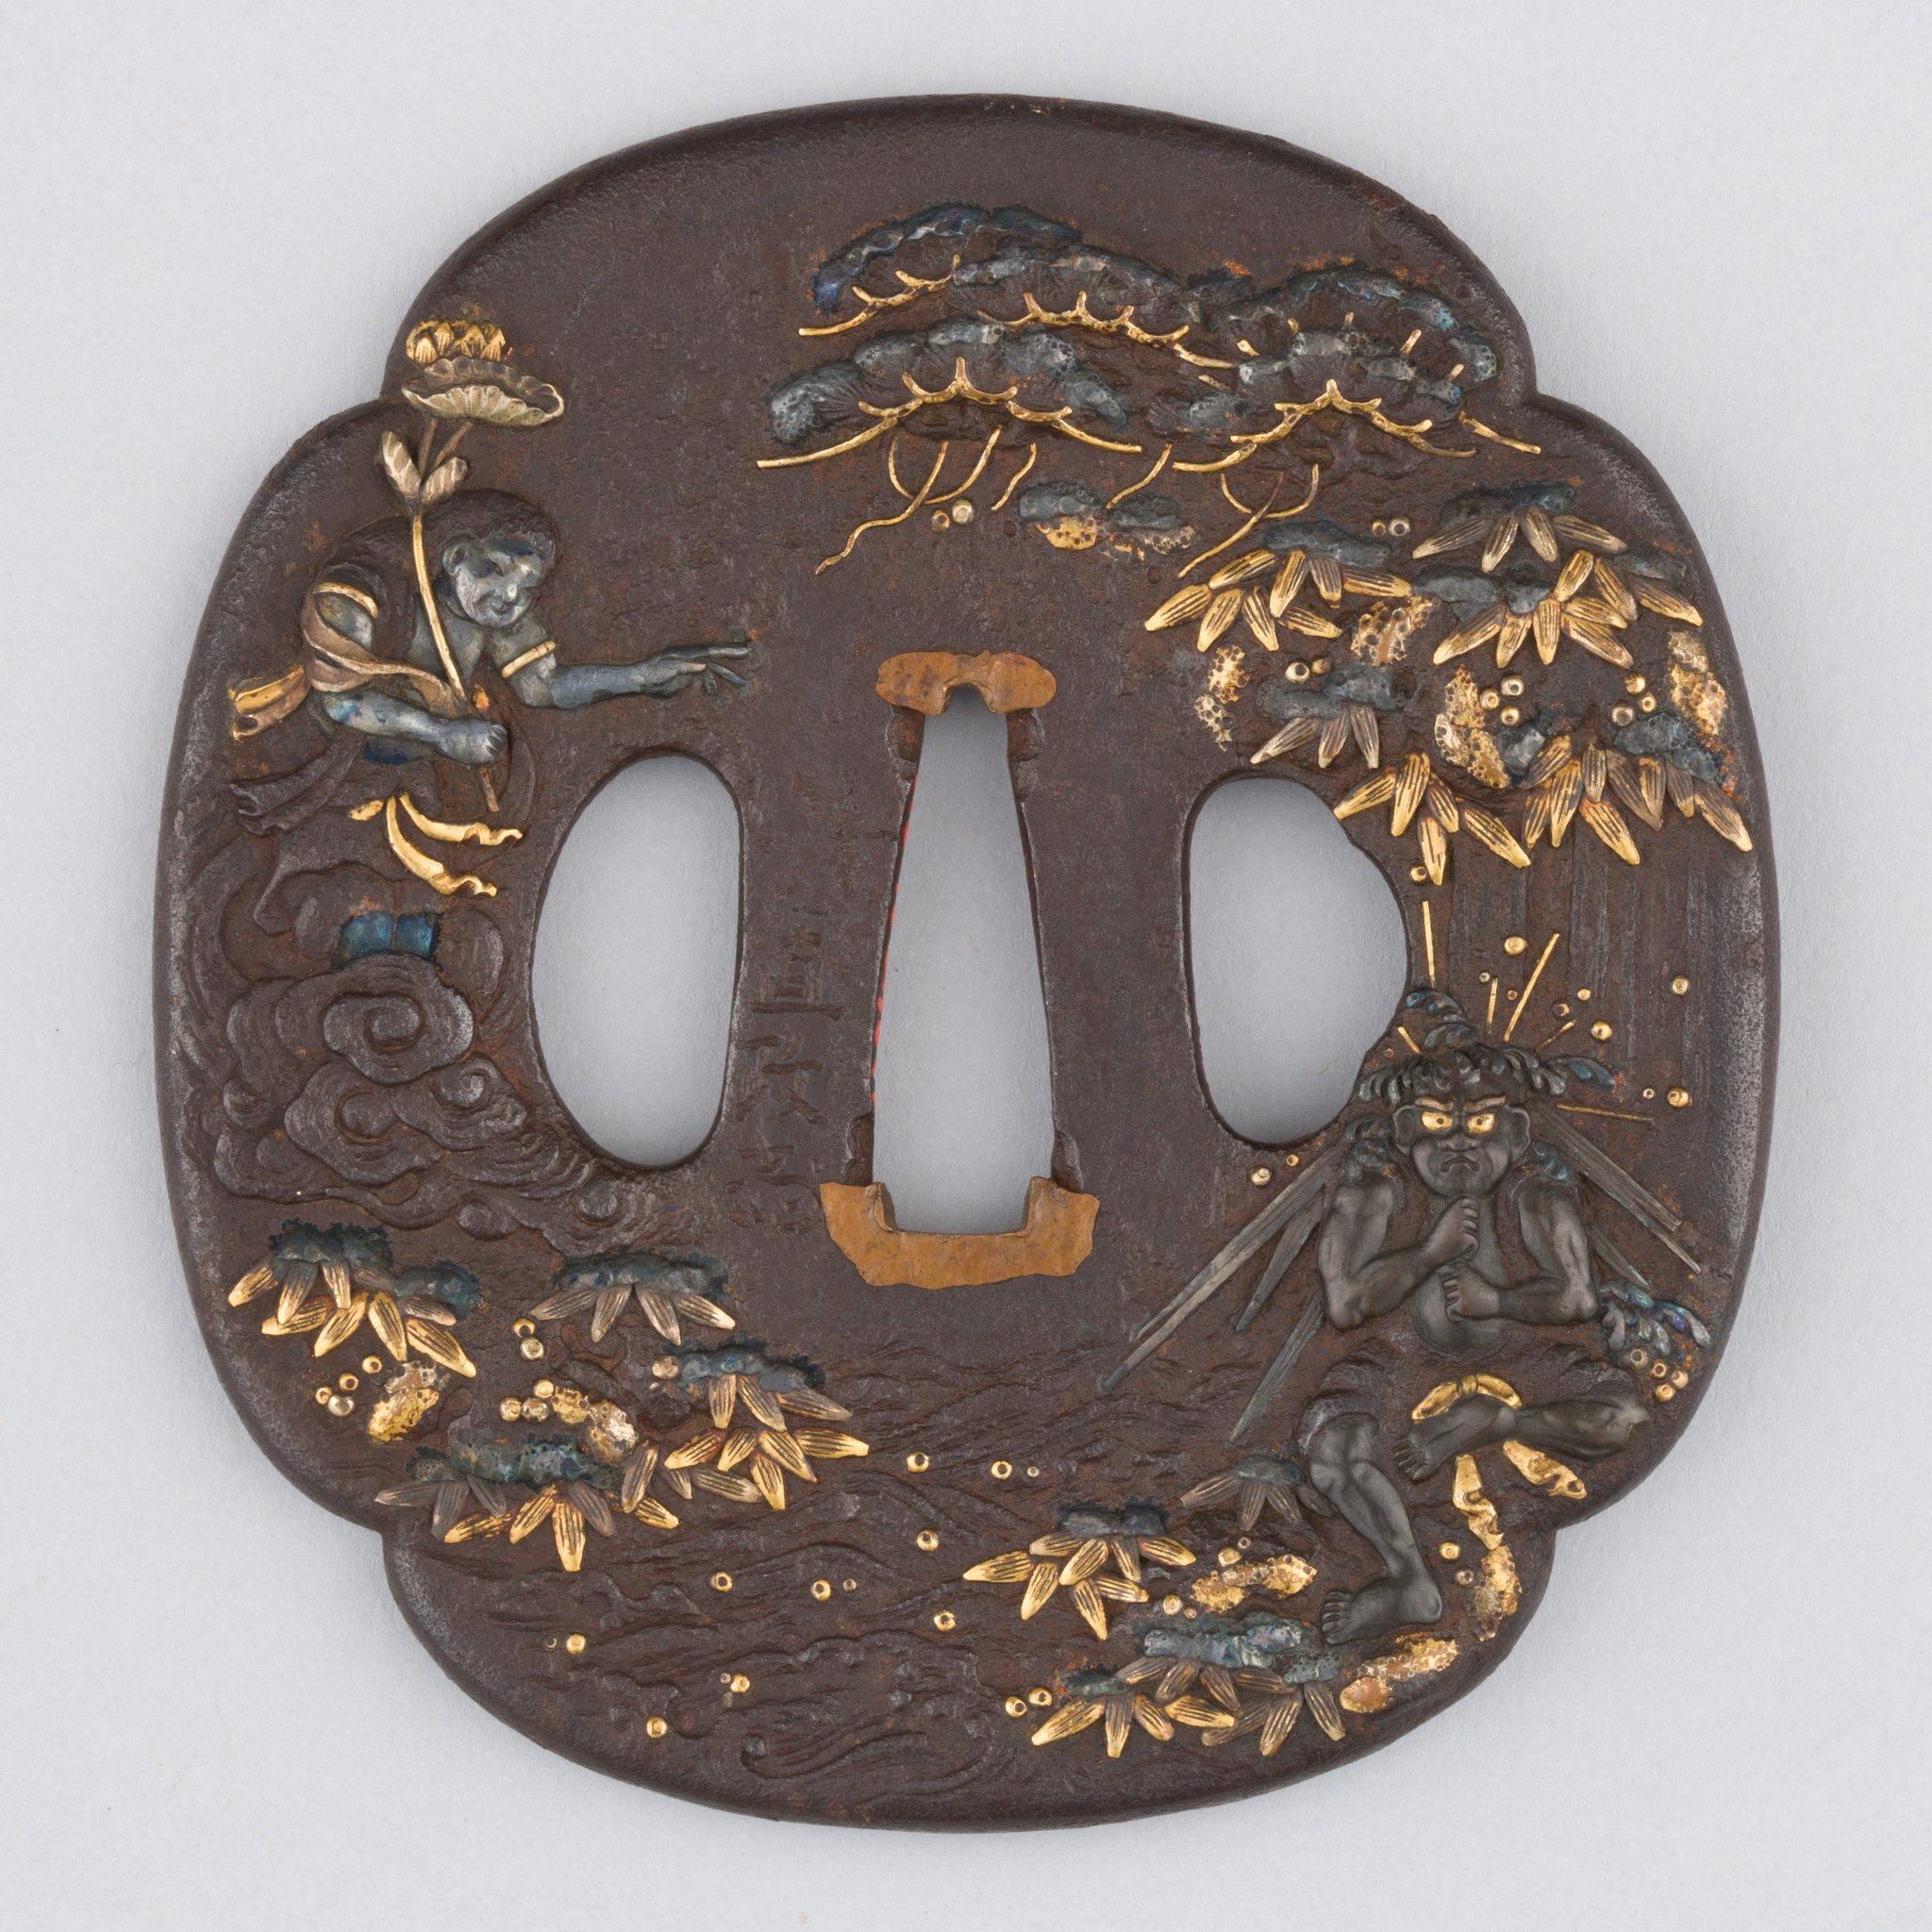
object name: sword guard tsuba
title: Sword Guard (Tsuba)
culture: japanese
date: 1615-1868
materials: copper, gold, iron, silver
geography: japan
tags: human figures,plants